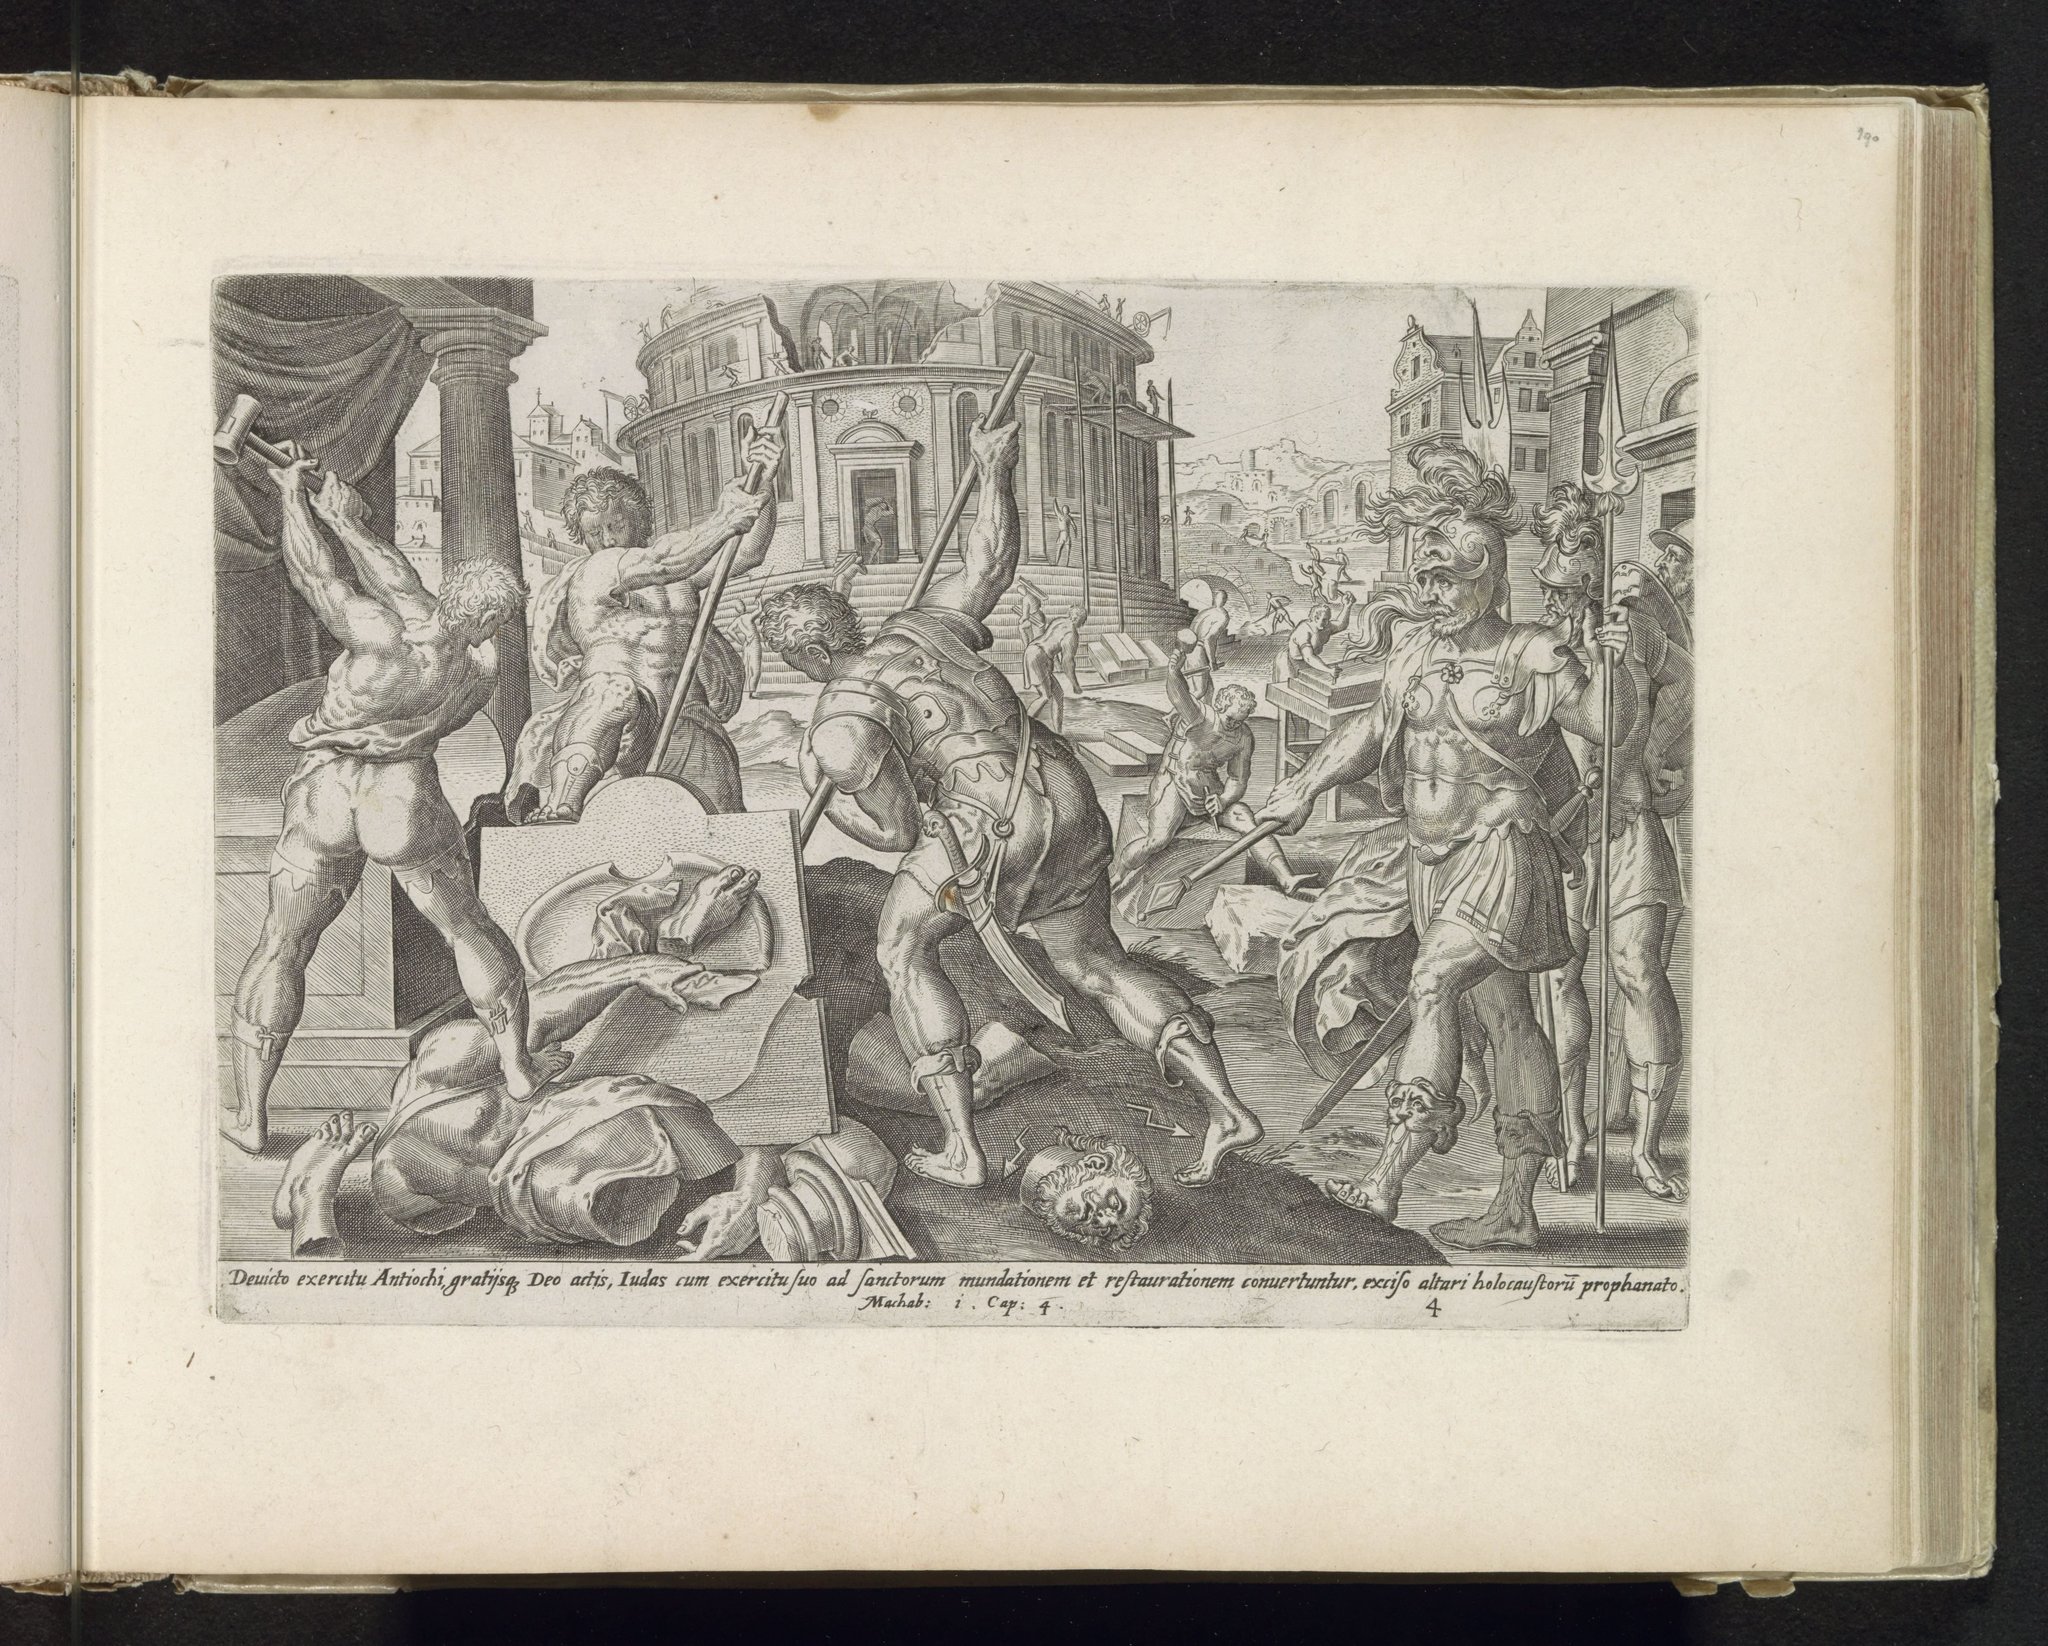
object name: album leaf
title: Geschiedenis van de Makkabeeën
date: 1585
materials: paper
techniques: engraving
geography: antwerp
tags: judas maccabeus has the temple purified and re-dedicated (1 maccabees 4:36-58)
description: Judas Makkabeüs beveelt een aantal wetsgetrouwe priesters het heiligdom te reinigen en de stenen die het altaar ontwijd hebben af te voeren naar een onreine plaats. Het ontwijde brandofferaltaar wordt afgebroken. Onder de voorstelling een verwijzing in het Latijn naar de Bijbeltekst in 1 Makk. 4. Deze prent maakt deel uit van een album.